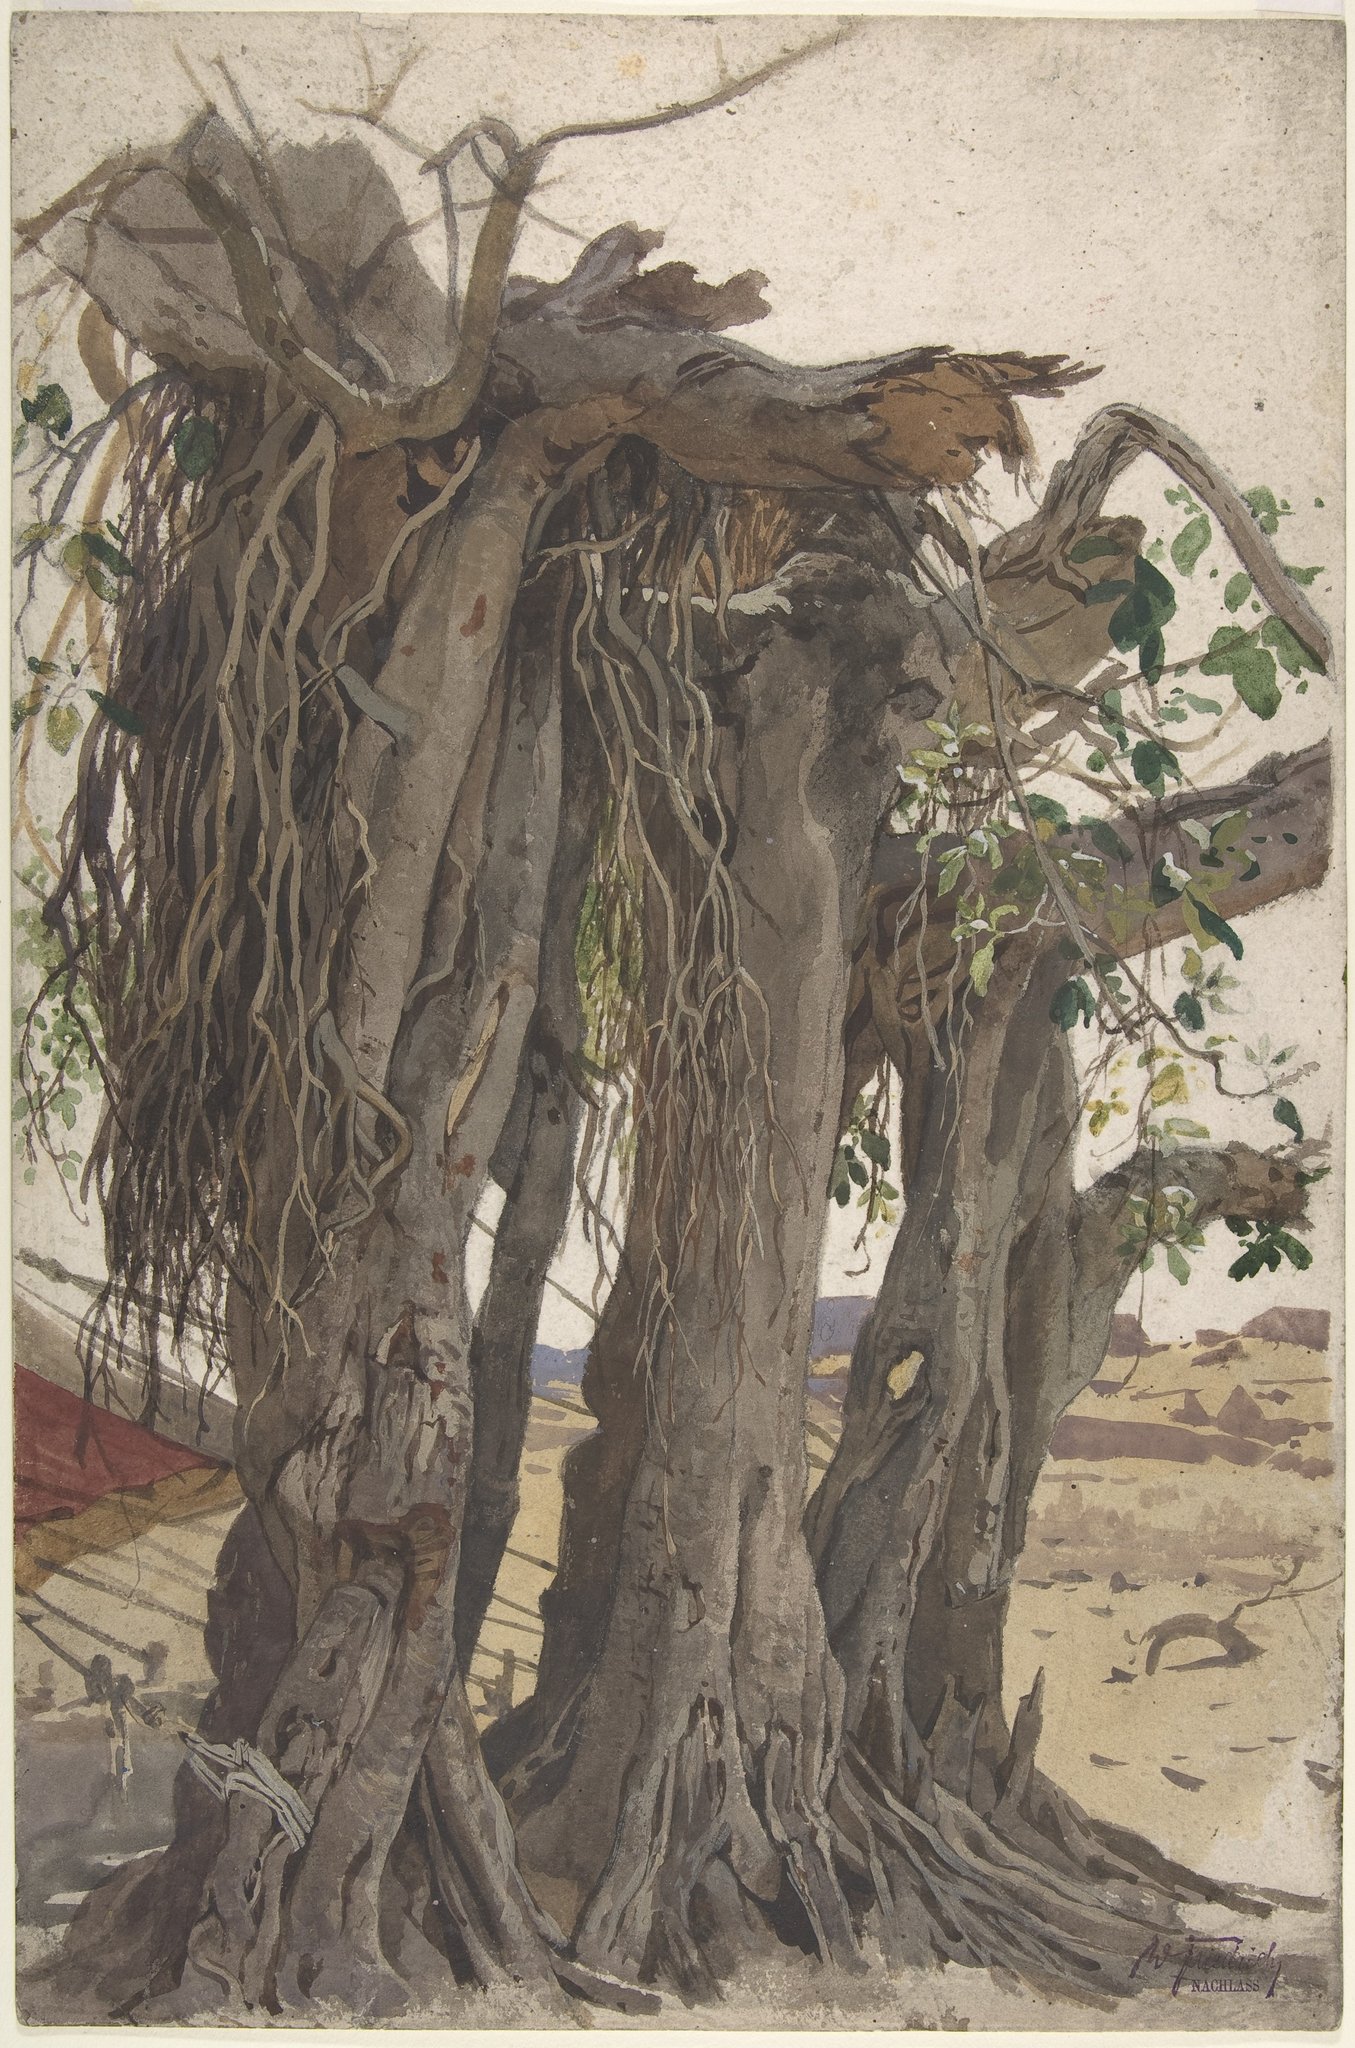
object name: drawing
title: Study of a Stump with Aerial Roots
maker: woldemar friedrich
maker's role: artist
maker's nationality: german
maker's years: 1846-1910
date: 1834-1933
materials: paint, graphite, watercolor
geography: germany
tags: trees